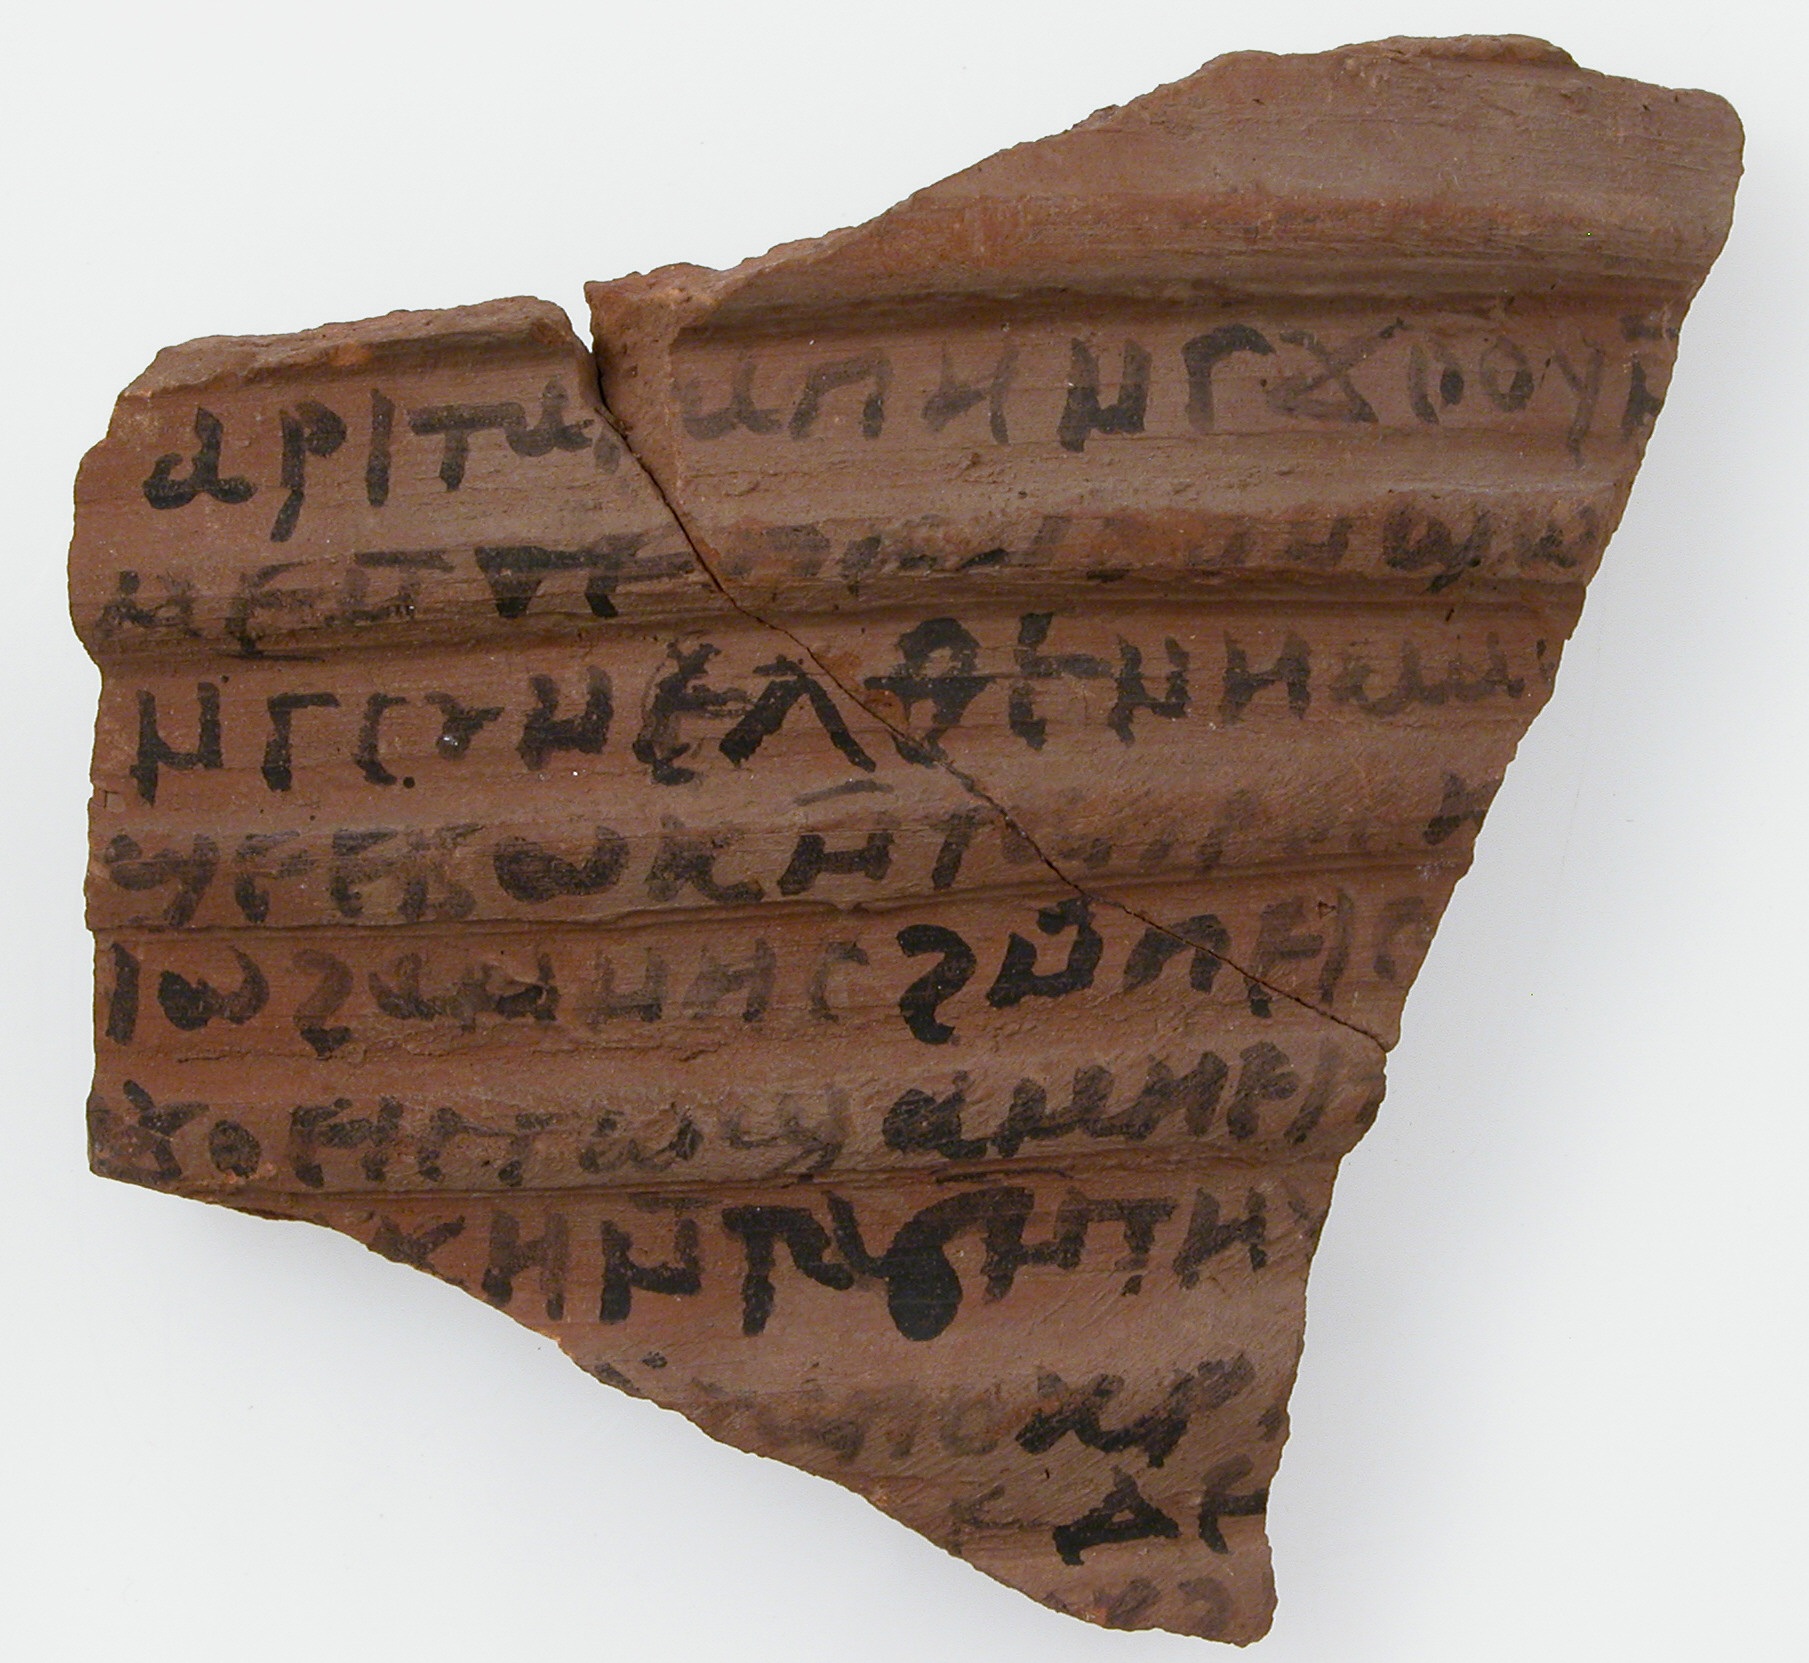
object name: ostrakon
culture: coptic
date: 601-700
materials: ink, pottery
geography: egypt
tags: coptic